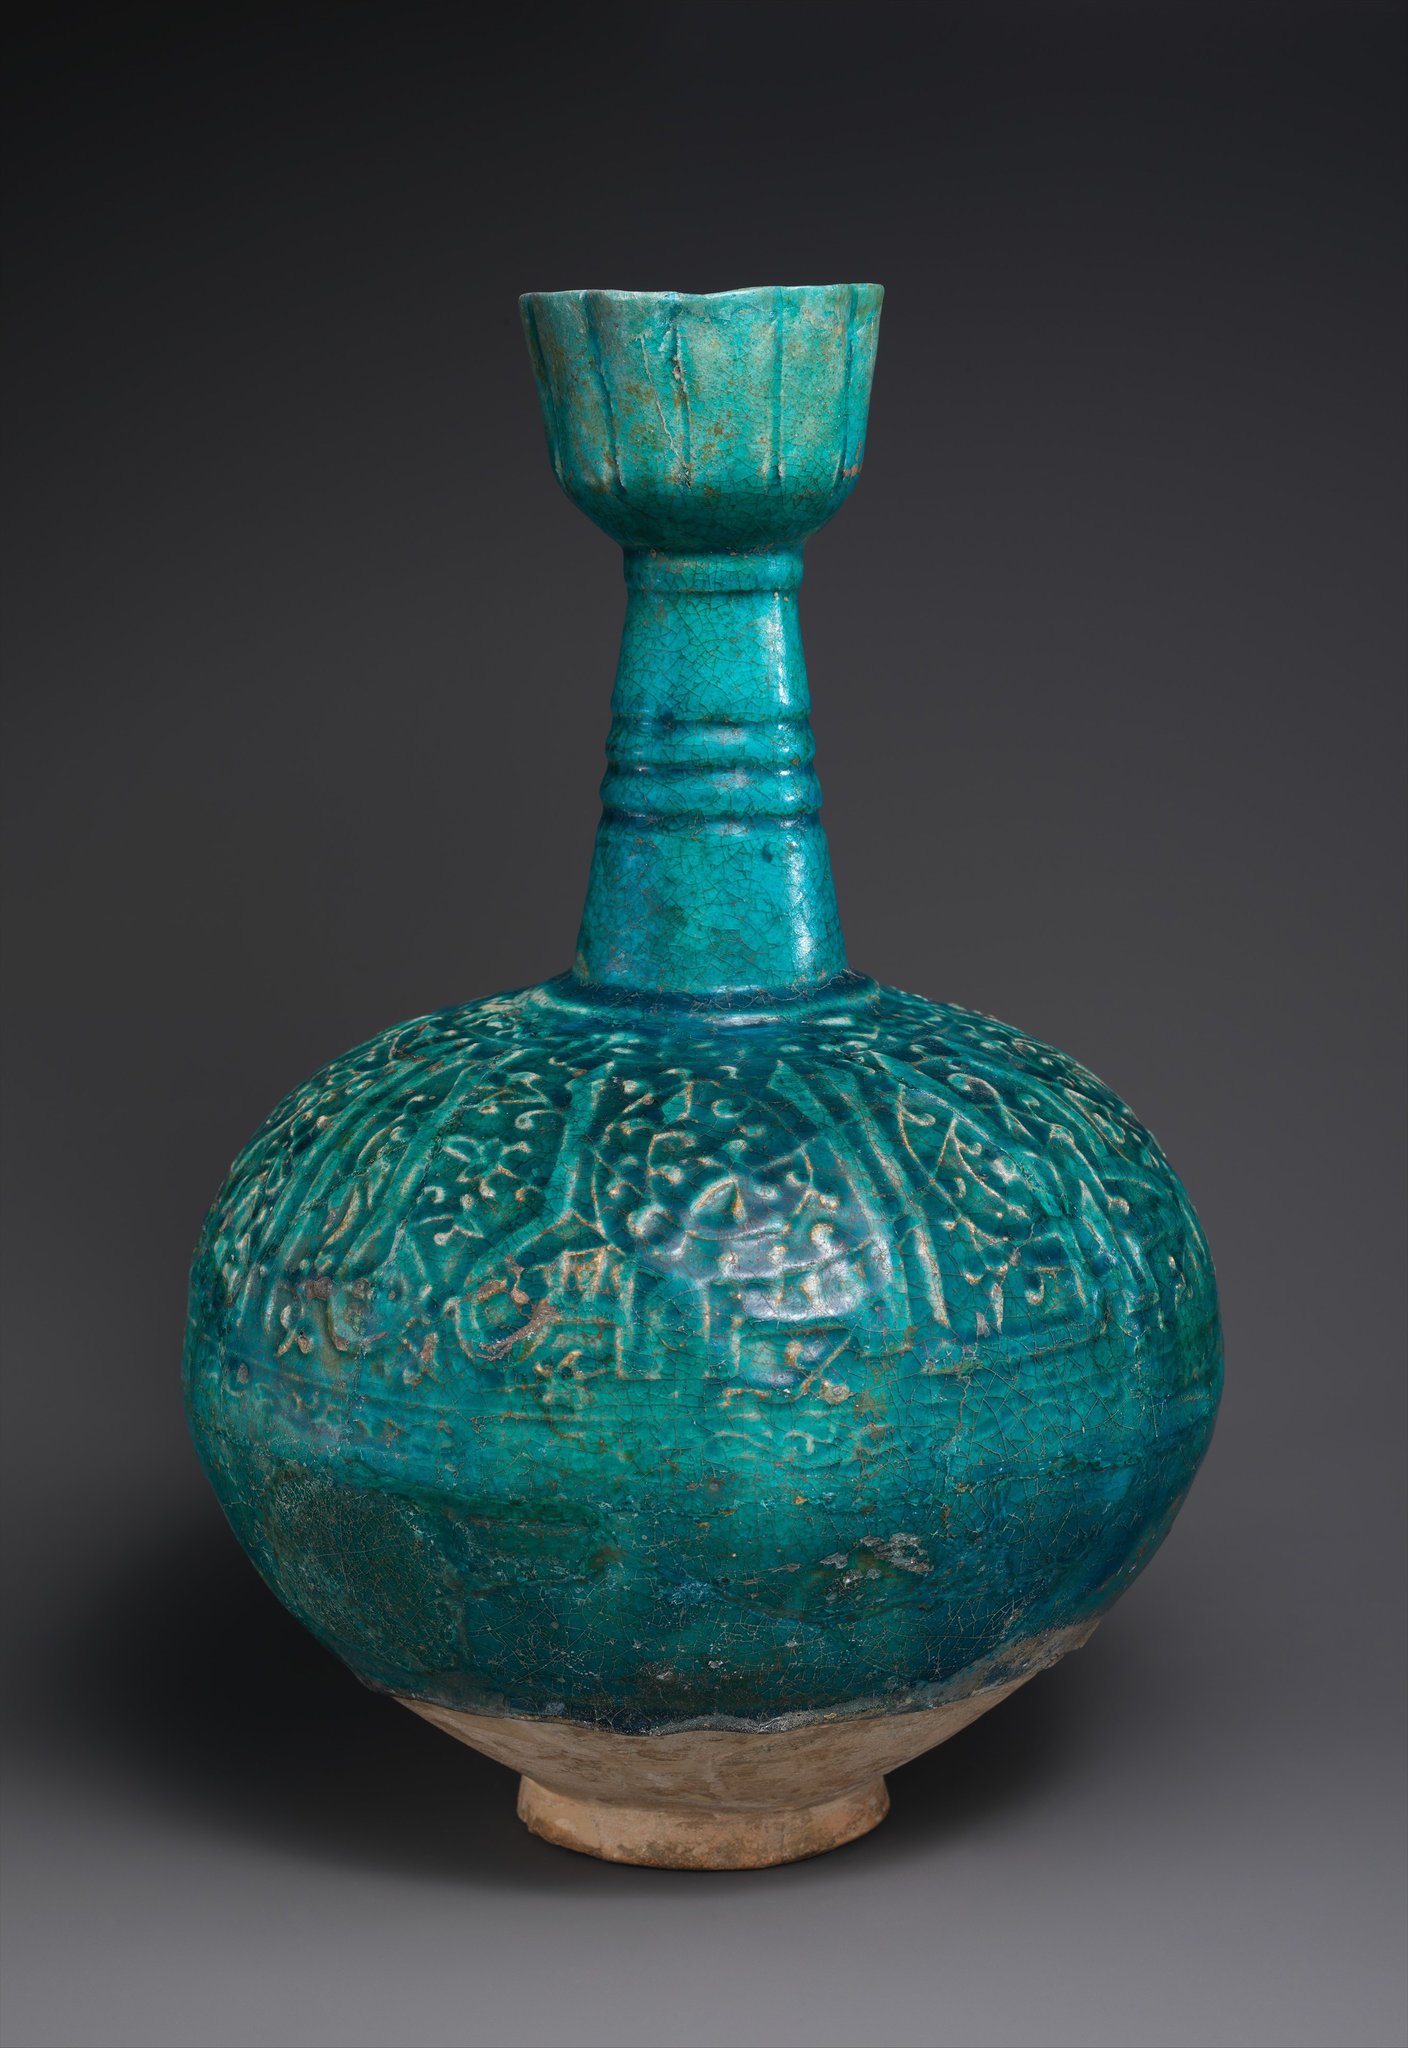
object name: bottle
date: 1067-1133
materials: earthenware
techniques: molding, relief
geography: iran